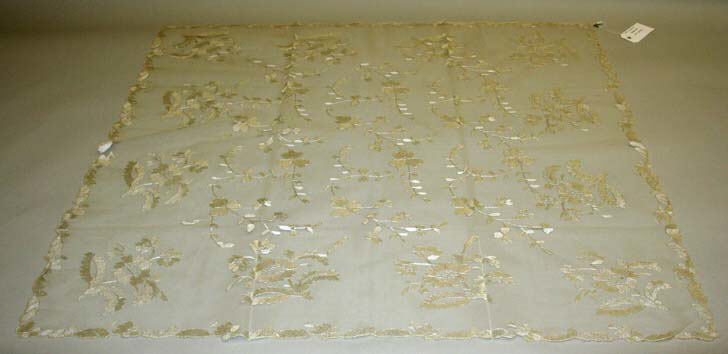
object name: wedding veil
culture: spanish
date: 1801-1900